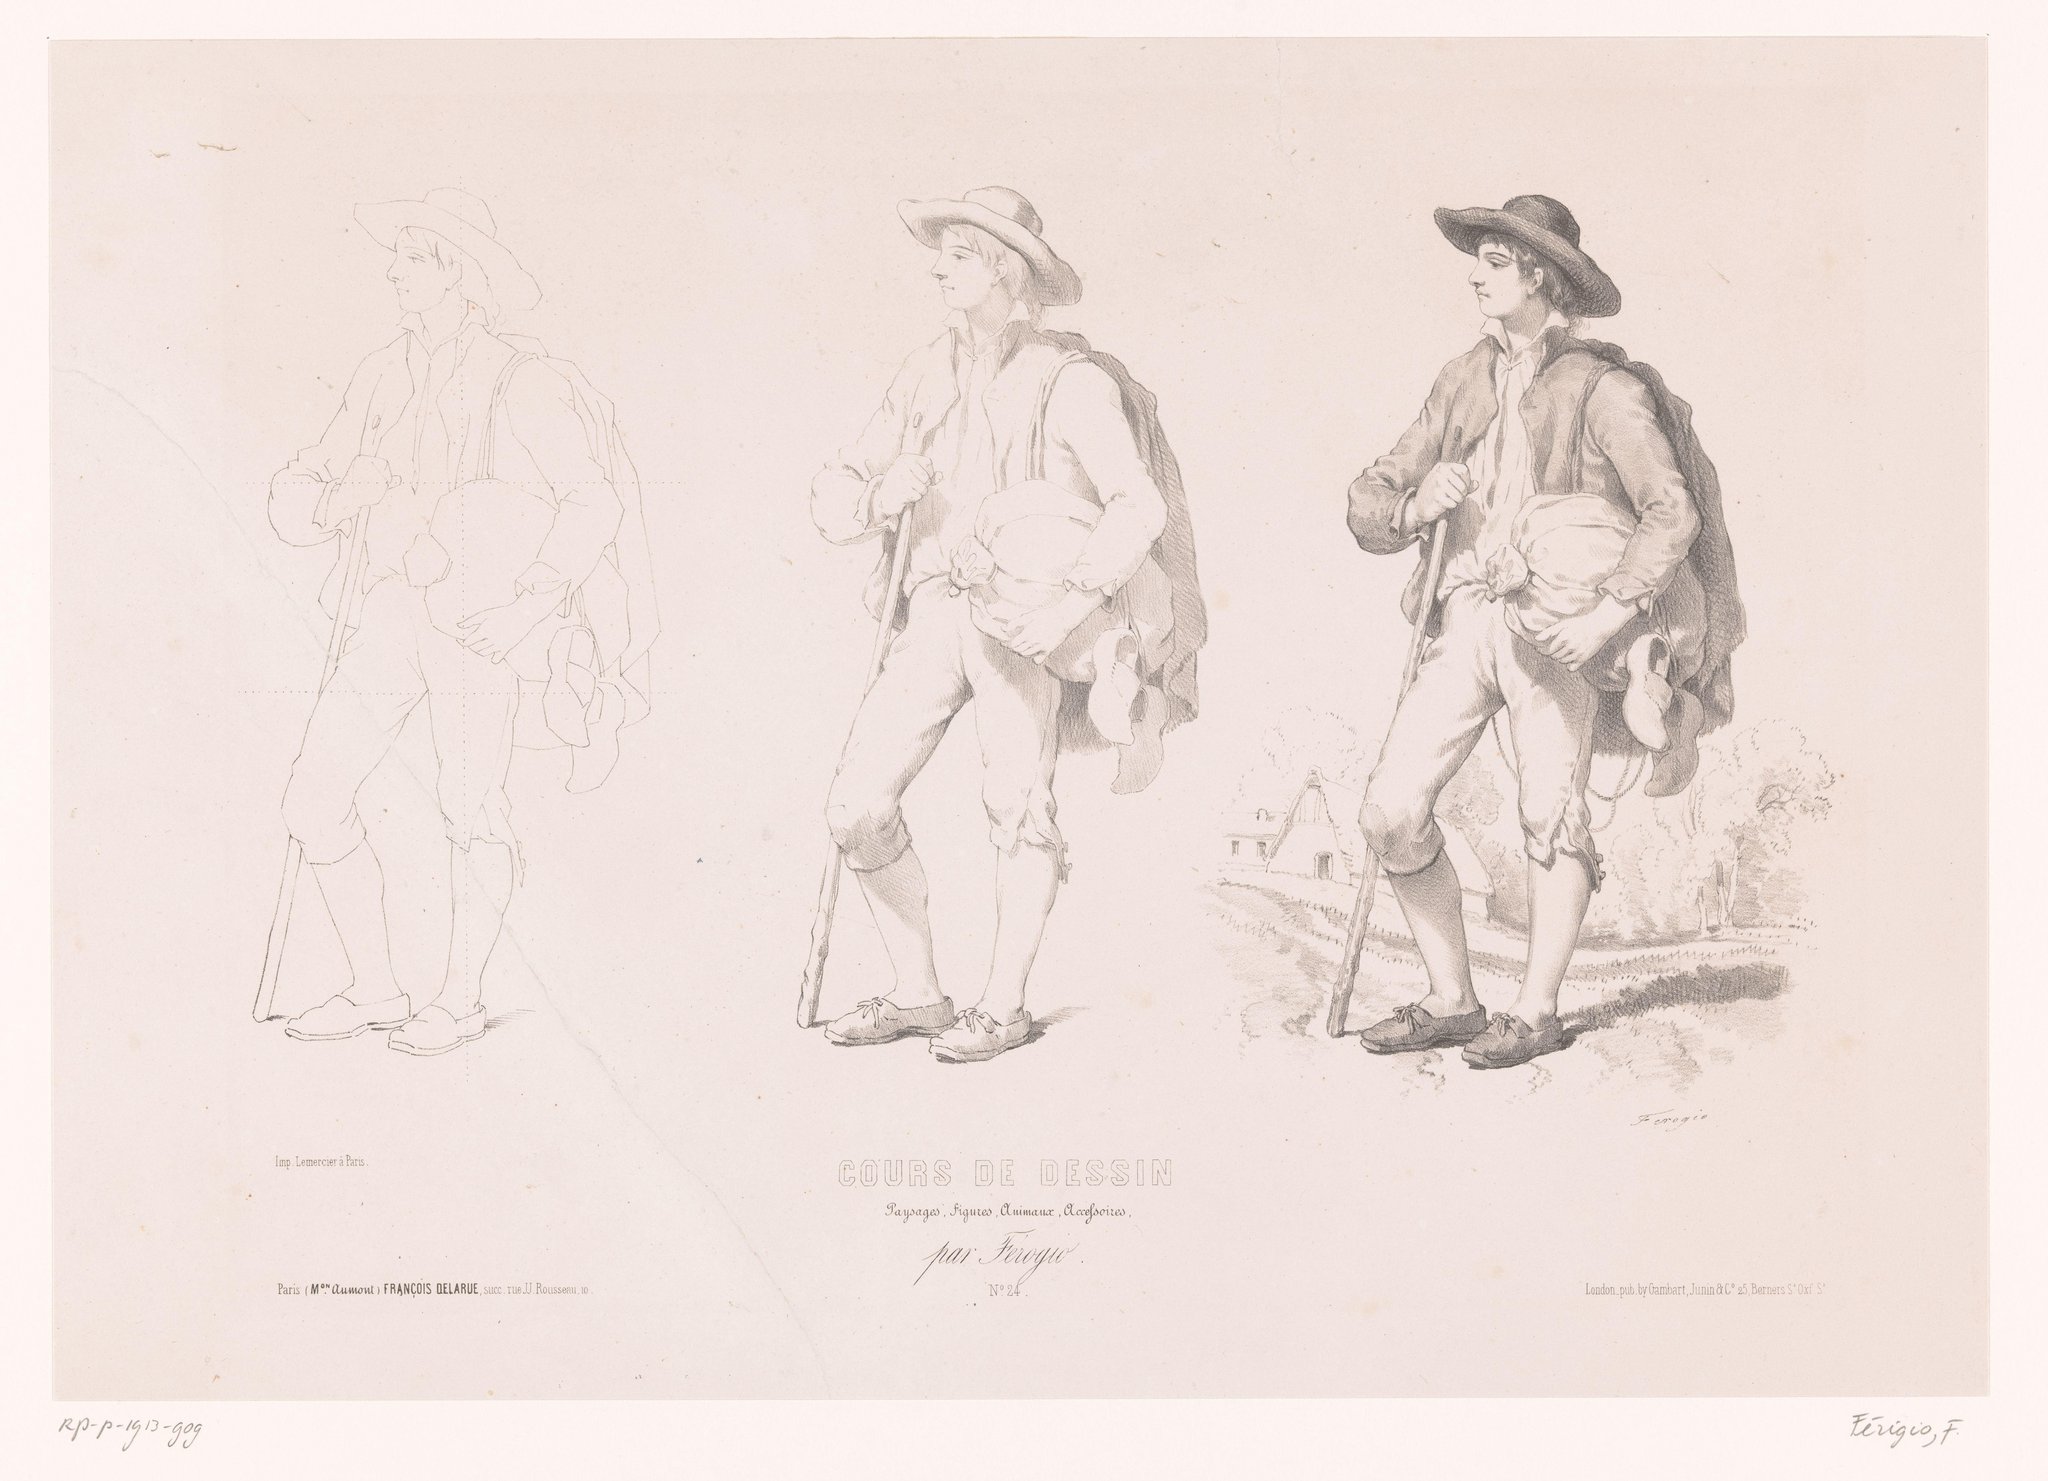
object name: print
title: Reiziger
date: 1845-1846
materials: paper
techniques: lithograph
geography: paris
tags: 'en route', traveller under way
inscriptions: collector's mark: Lugt 2228a